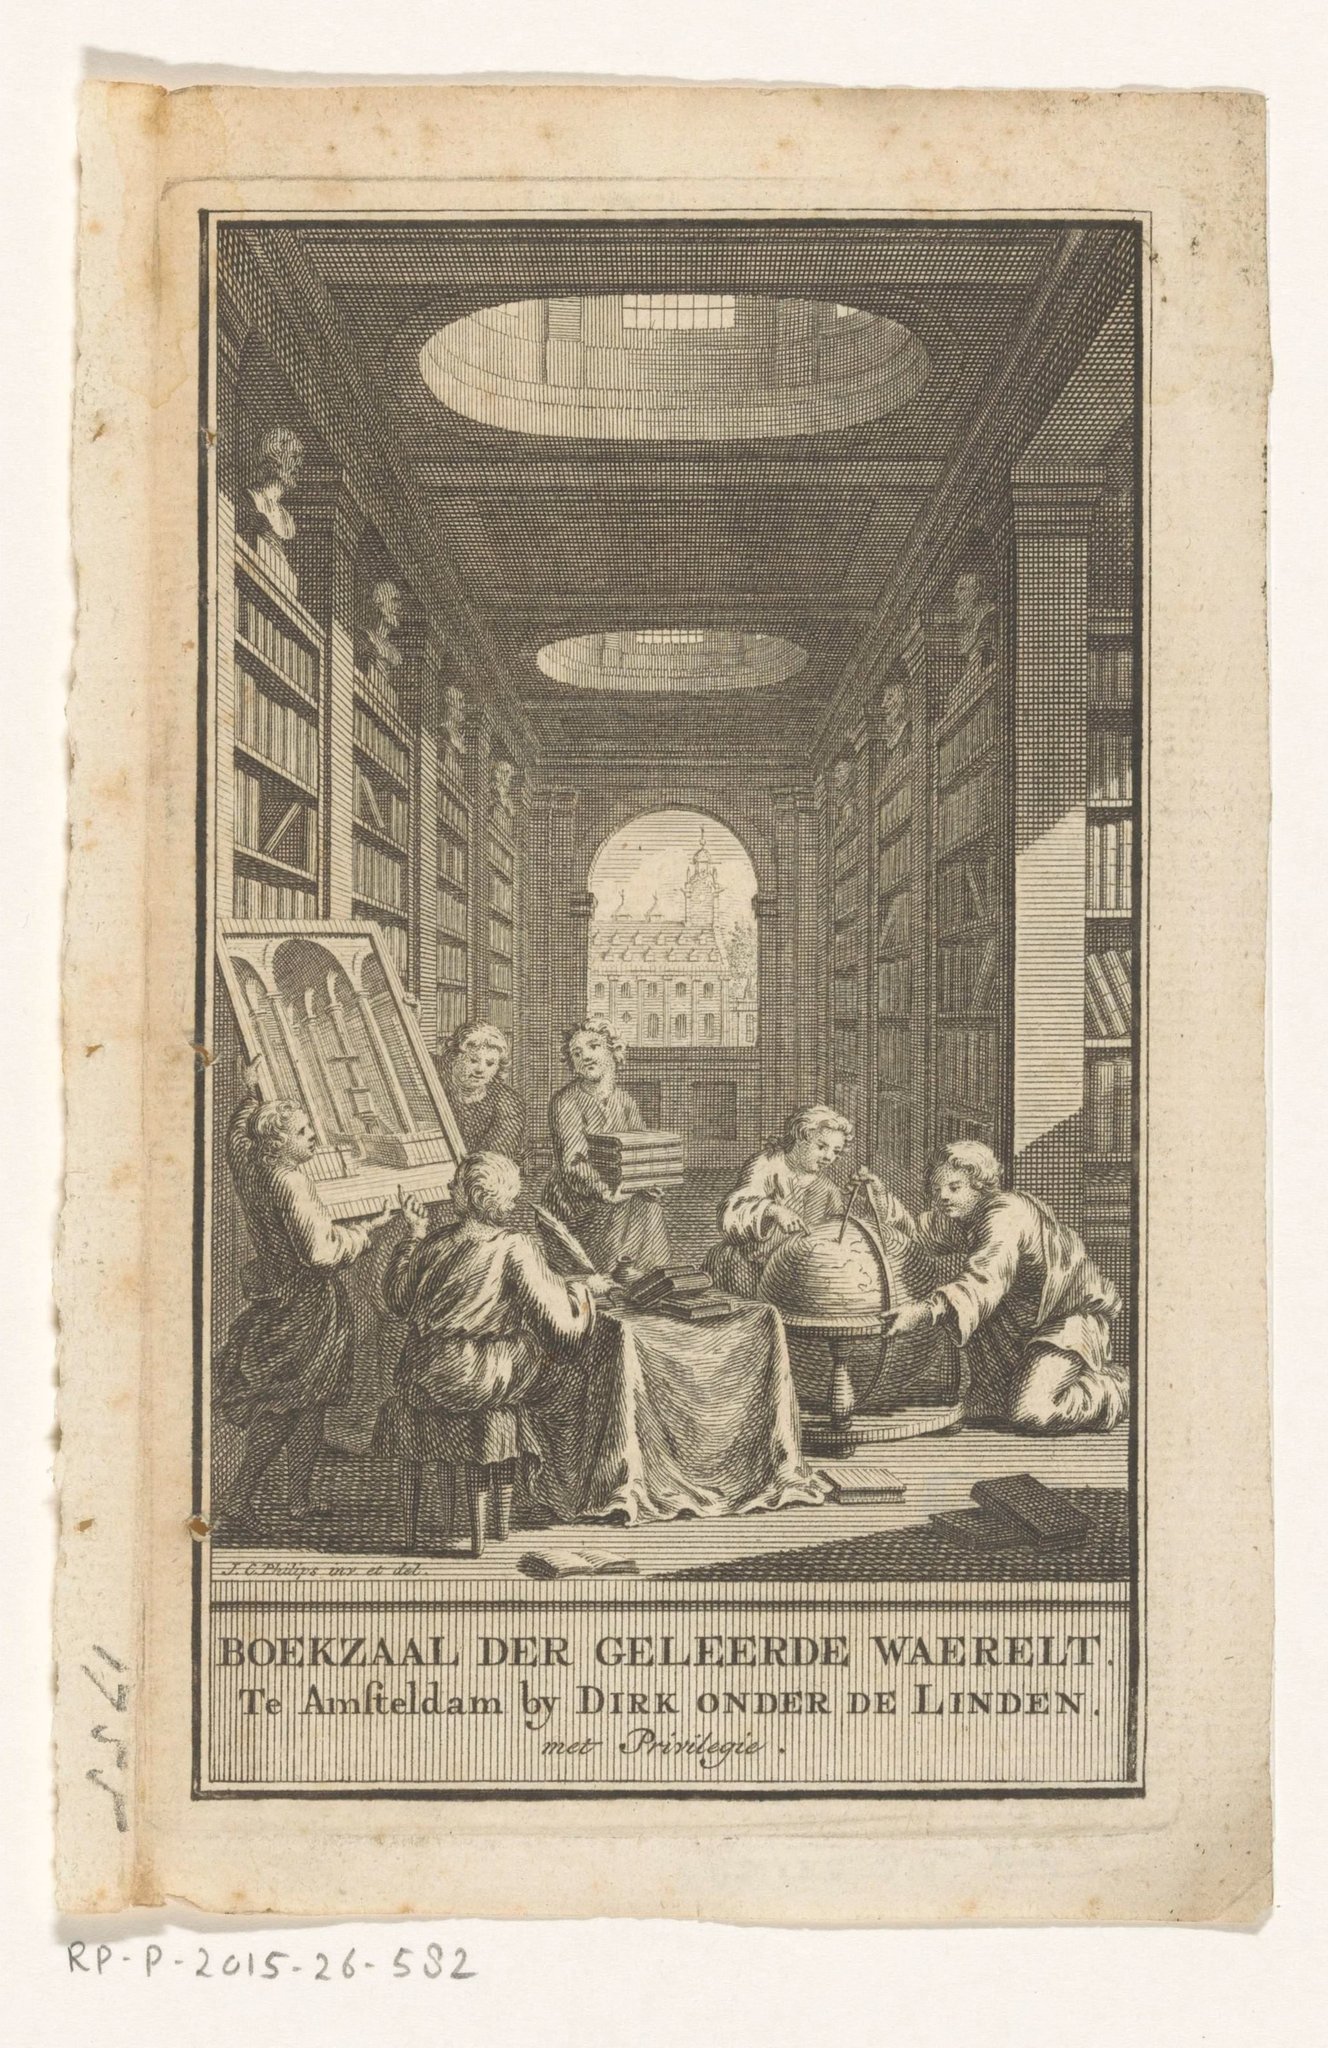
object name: titelblad, titelpagina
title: Interieur van een bibliotheek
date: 1747-1769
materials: paper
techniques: engraving, etching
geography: amsterdam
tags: bookshelves, study; 'studiolo'; library, globe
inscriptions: collector's mark: Lugt 4779, watermark, collector's mark: Lugt 2228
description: Interieur met boekenkasten langs de wanden, in het midden een man met een schrijfveer achter een tafel die kijkt naar een schilderij van een kerkinterieur, vastgehouden door twee andere personen. Ernaast een persoon met een stapel boeken en twee figuren die een globe bestuderen, een raam biedt uitzicht op een gebouw met een toren.